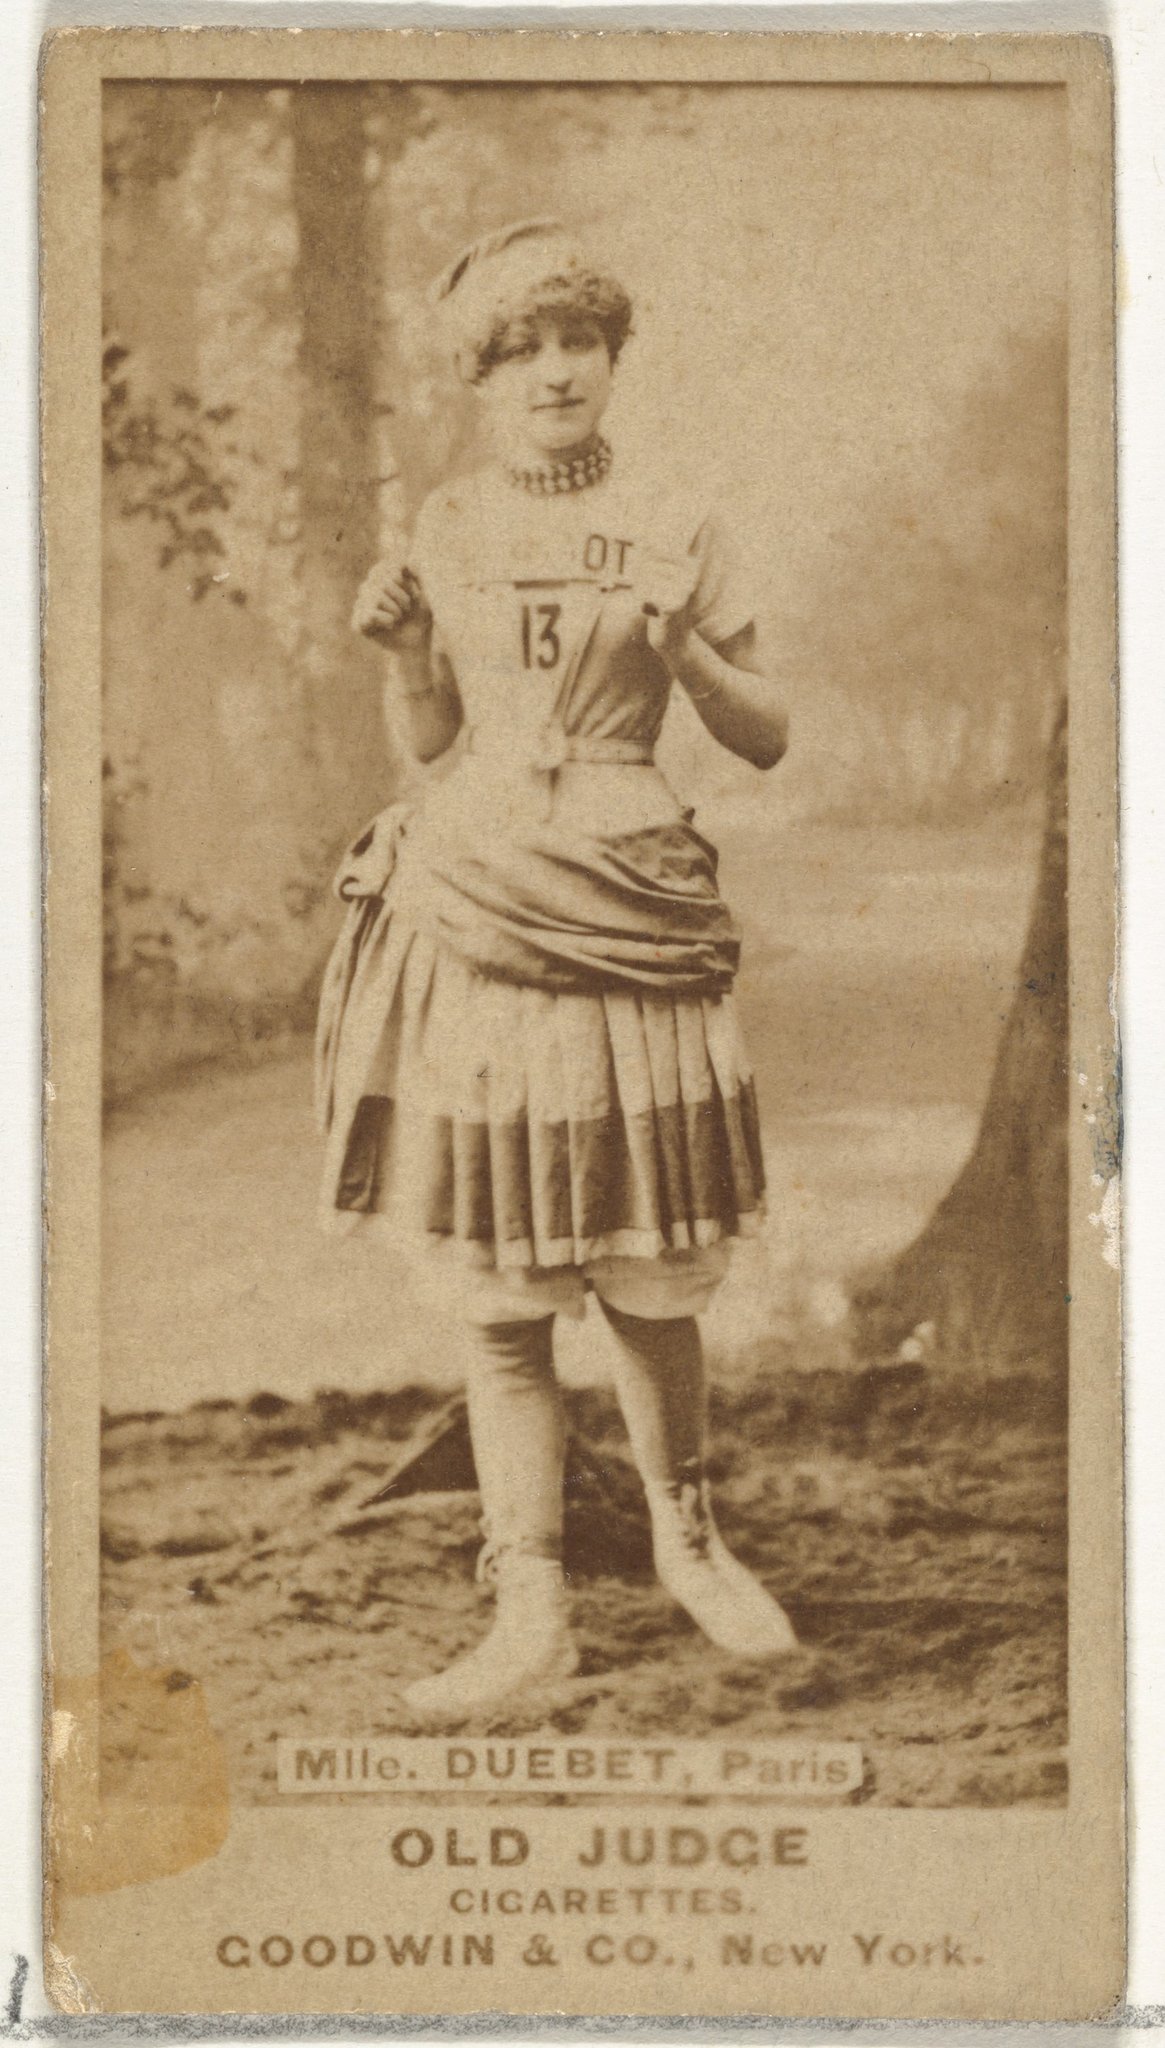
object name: photograph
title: Mlle. Duebet, Paris, from the Actors and Actresses series (N171) for Old Judge Cigarettes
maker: goodwin & company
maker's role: publisher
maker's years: 1850-1950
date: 1886-1890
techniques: albumen silver print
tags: portraits,women,actresses